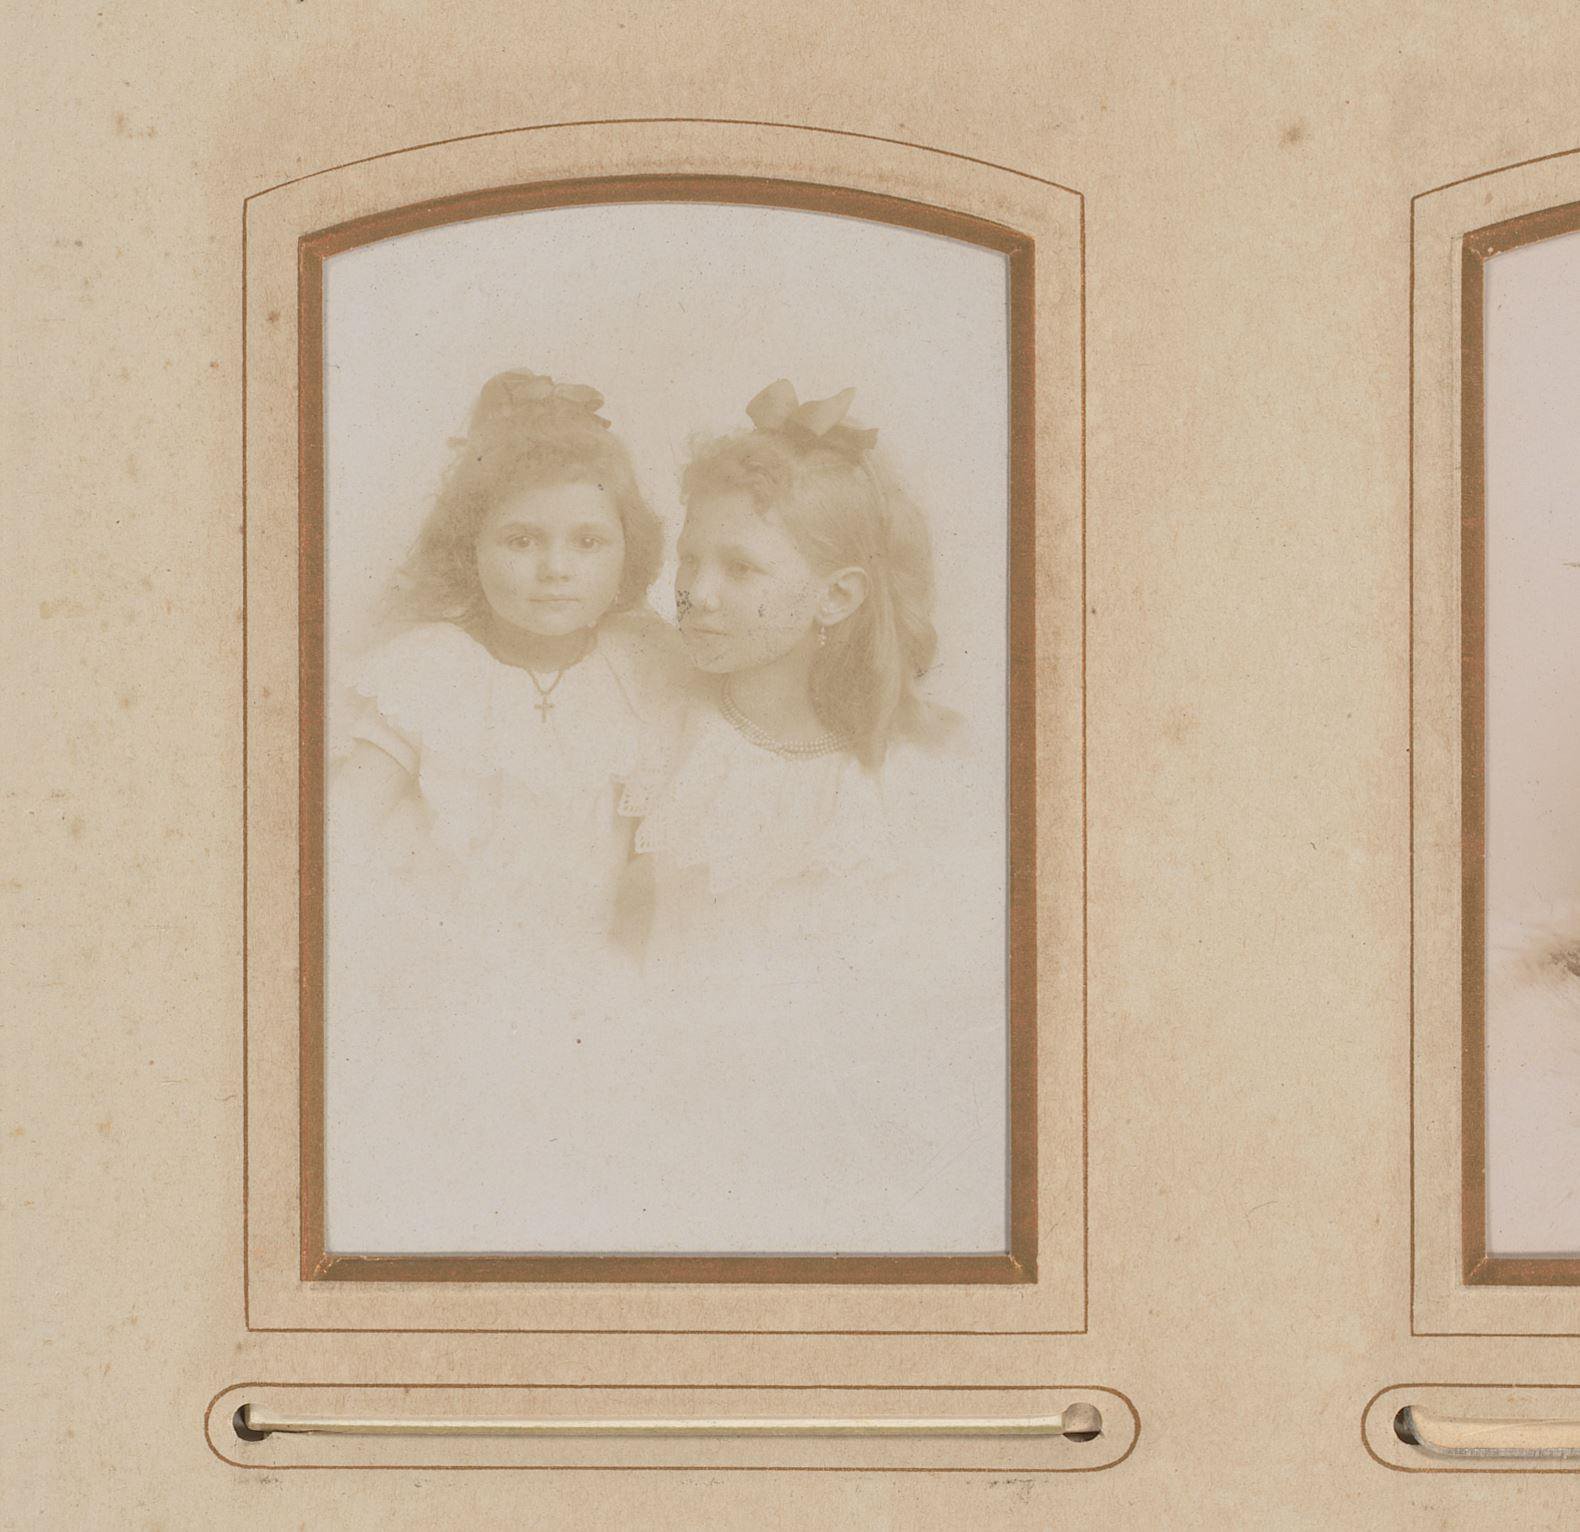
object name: album leaf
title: Portret van twee meisjes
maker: emile morren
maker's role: fotograaf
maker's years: 1865-1941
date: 1894-1914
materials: cardboard, celluloid, photographic support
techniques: collodion silver print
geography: leuven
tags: historical persons - bb - woman, girl (child between toddler and youth) (+ two persons)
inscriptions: inscription: ‘Photographie inaltérable au charbon./ Rue de Namur 18/ Louvain/ Emile Morren/ Onveranderlyke Lichtprentery./ Naamsche Straat 18/ Leuven/ Les clichés sont conservés./ De platen worden bewaard.’